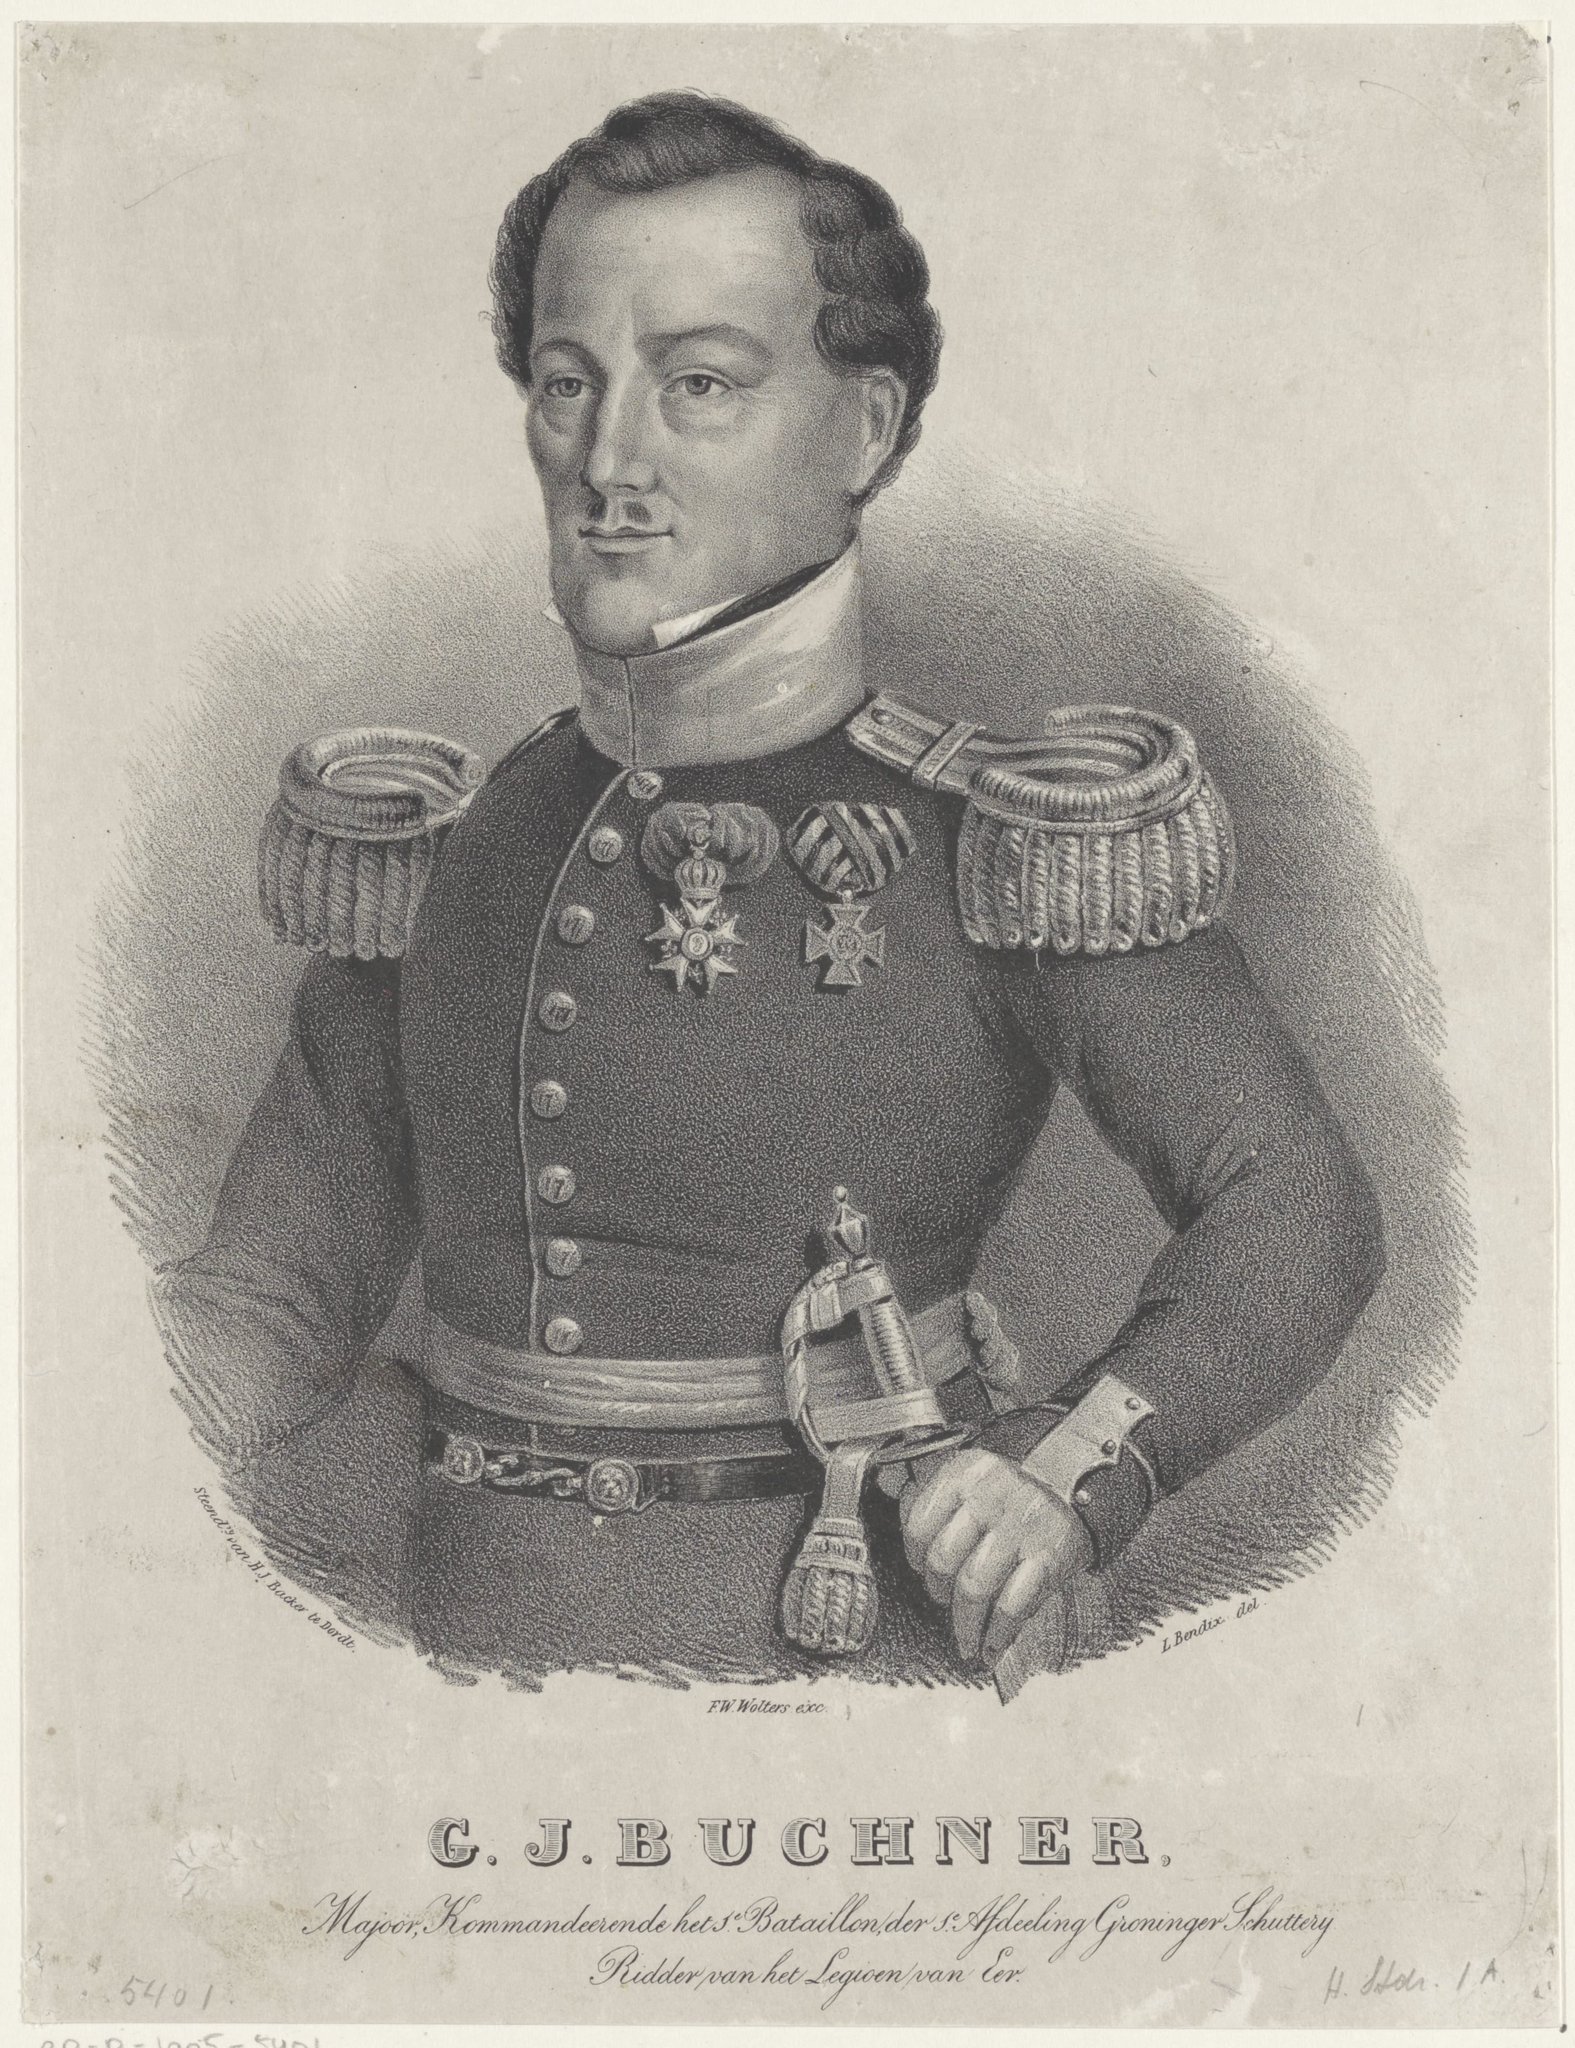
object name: print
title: Portret van majoor G.J. Buchner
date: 1822-1845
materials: paper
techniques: lithograph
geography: leeuwarden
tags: historical persons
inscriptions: collector's mark: Lugt 2228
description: De geportretteerde draagt twee ridderorden op zijn borst. Hij draagt een sabel dat hij met zijn linkerhand vasthoudt.